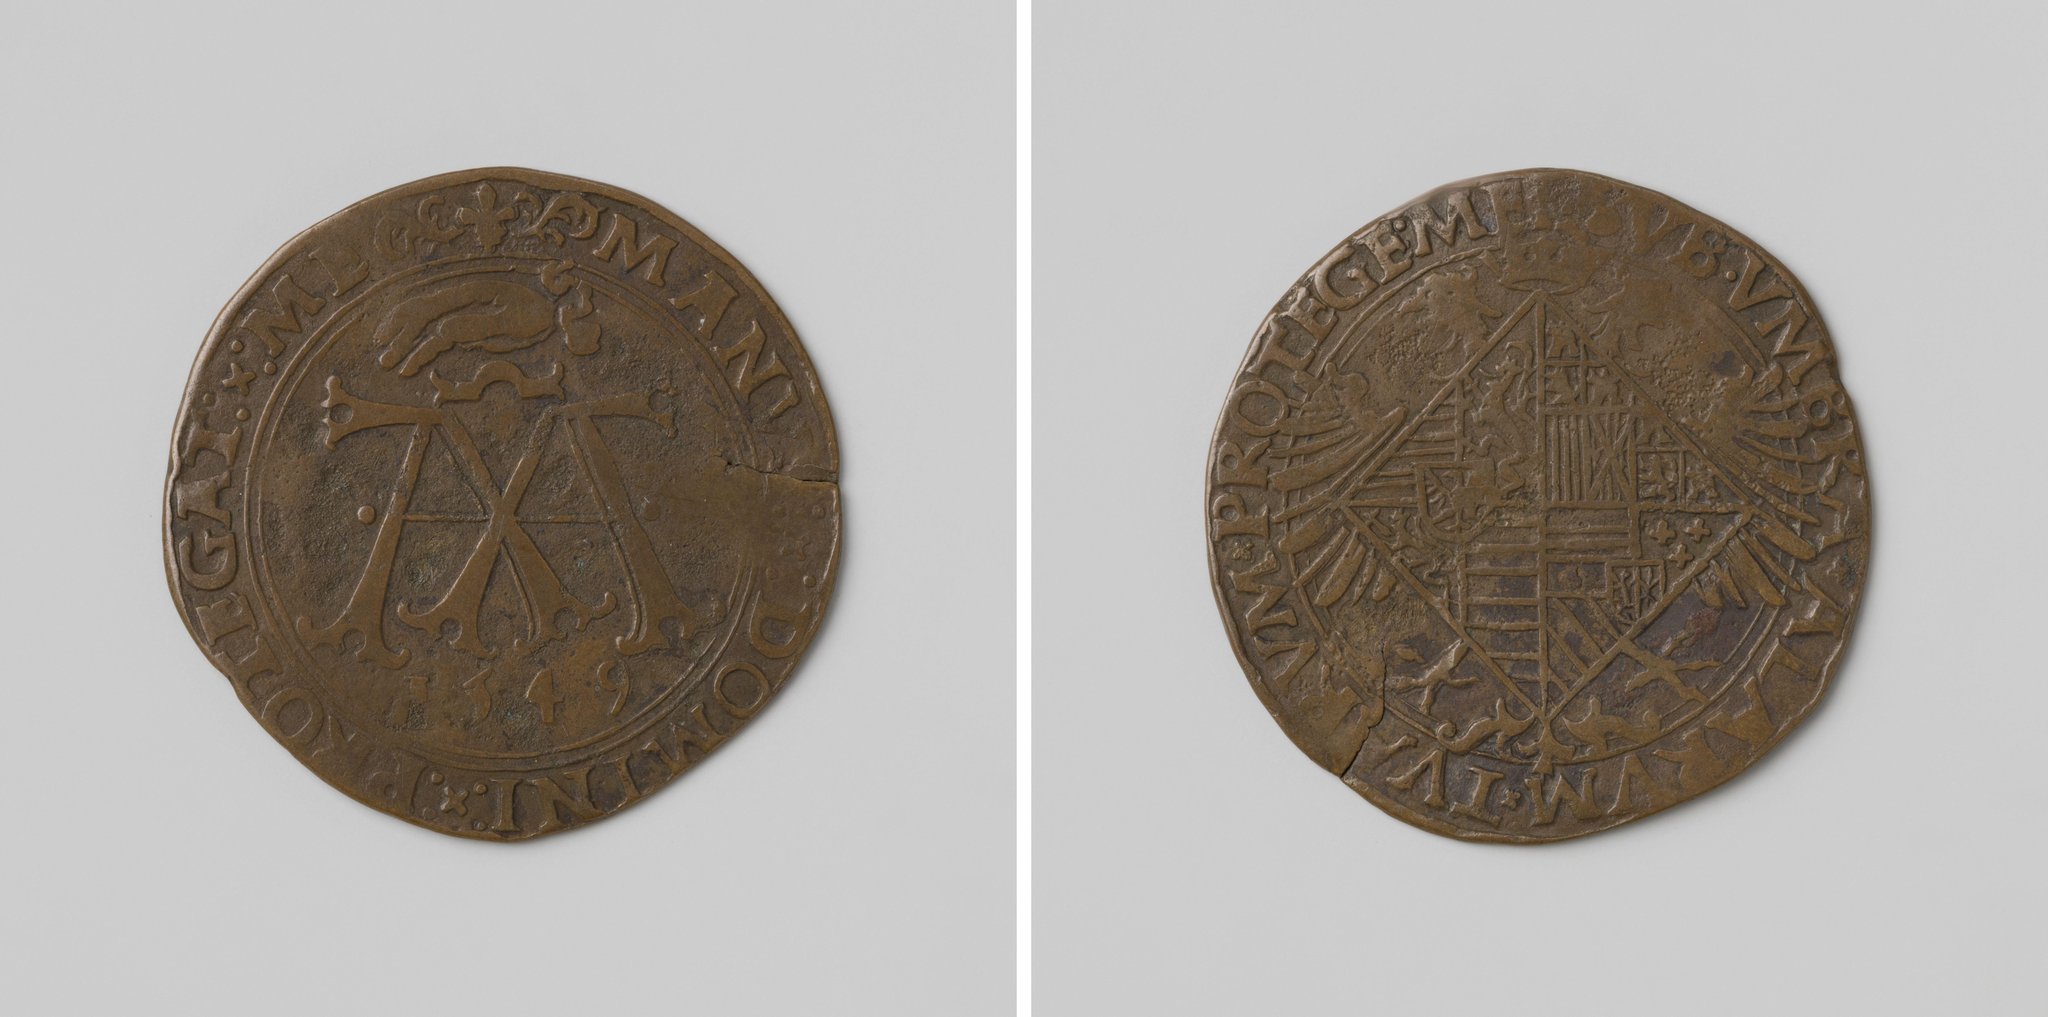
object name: jeton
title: Maria van Hongarije, landvoogdes der Nederlanden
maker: Anonymous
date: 1549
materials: copper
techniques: striking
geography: netherlands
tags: brussels, maria van hongarije (landvoogdes der nederlanden)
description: Koperen penning. Voorzijde: letter M onder hand en accolade, boven jaartal binnen omschrift. Keerzijde: tweekoppige adelaar onder kroon houdt ruitvormig wapenschild voor zich binnen omschrift